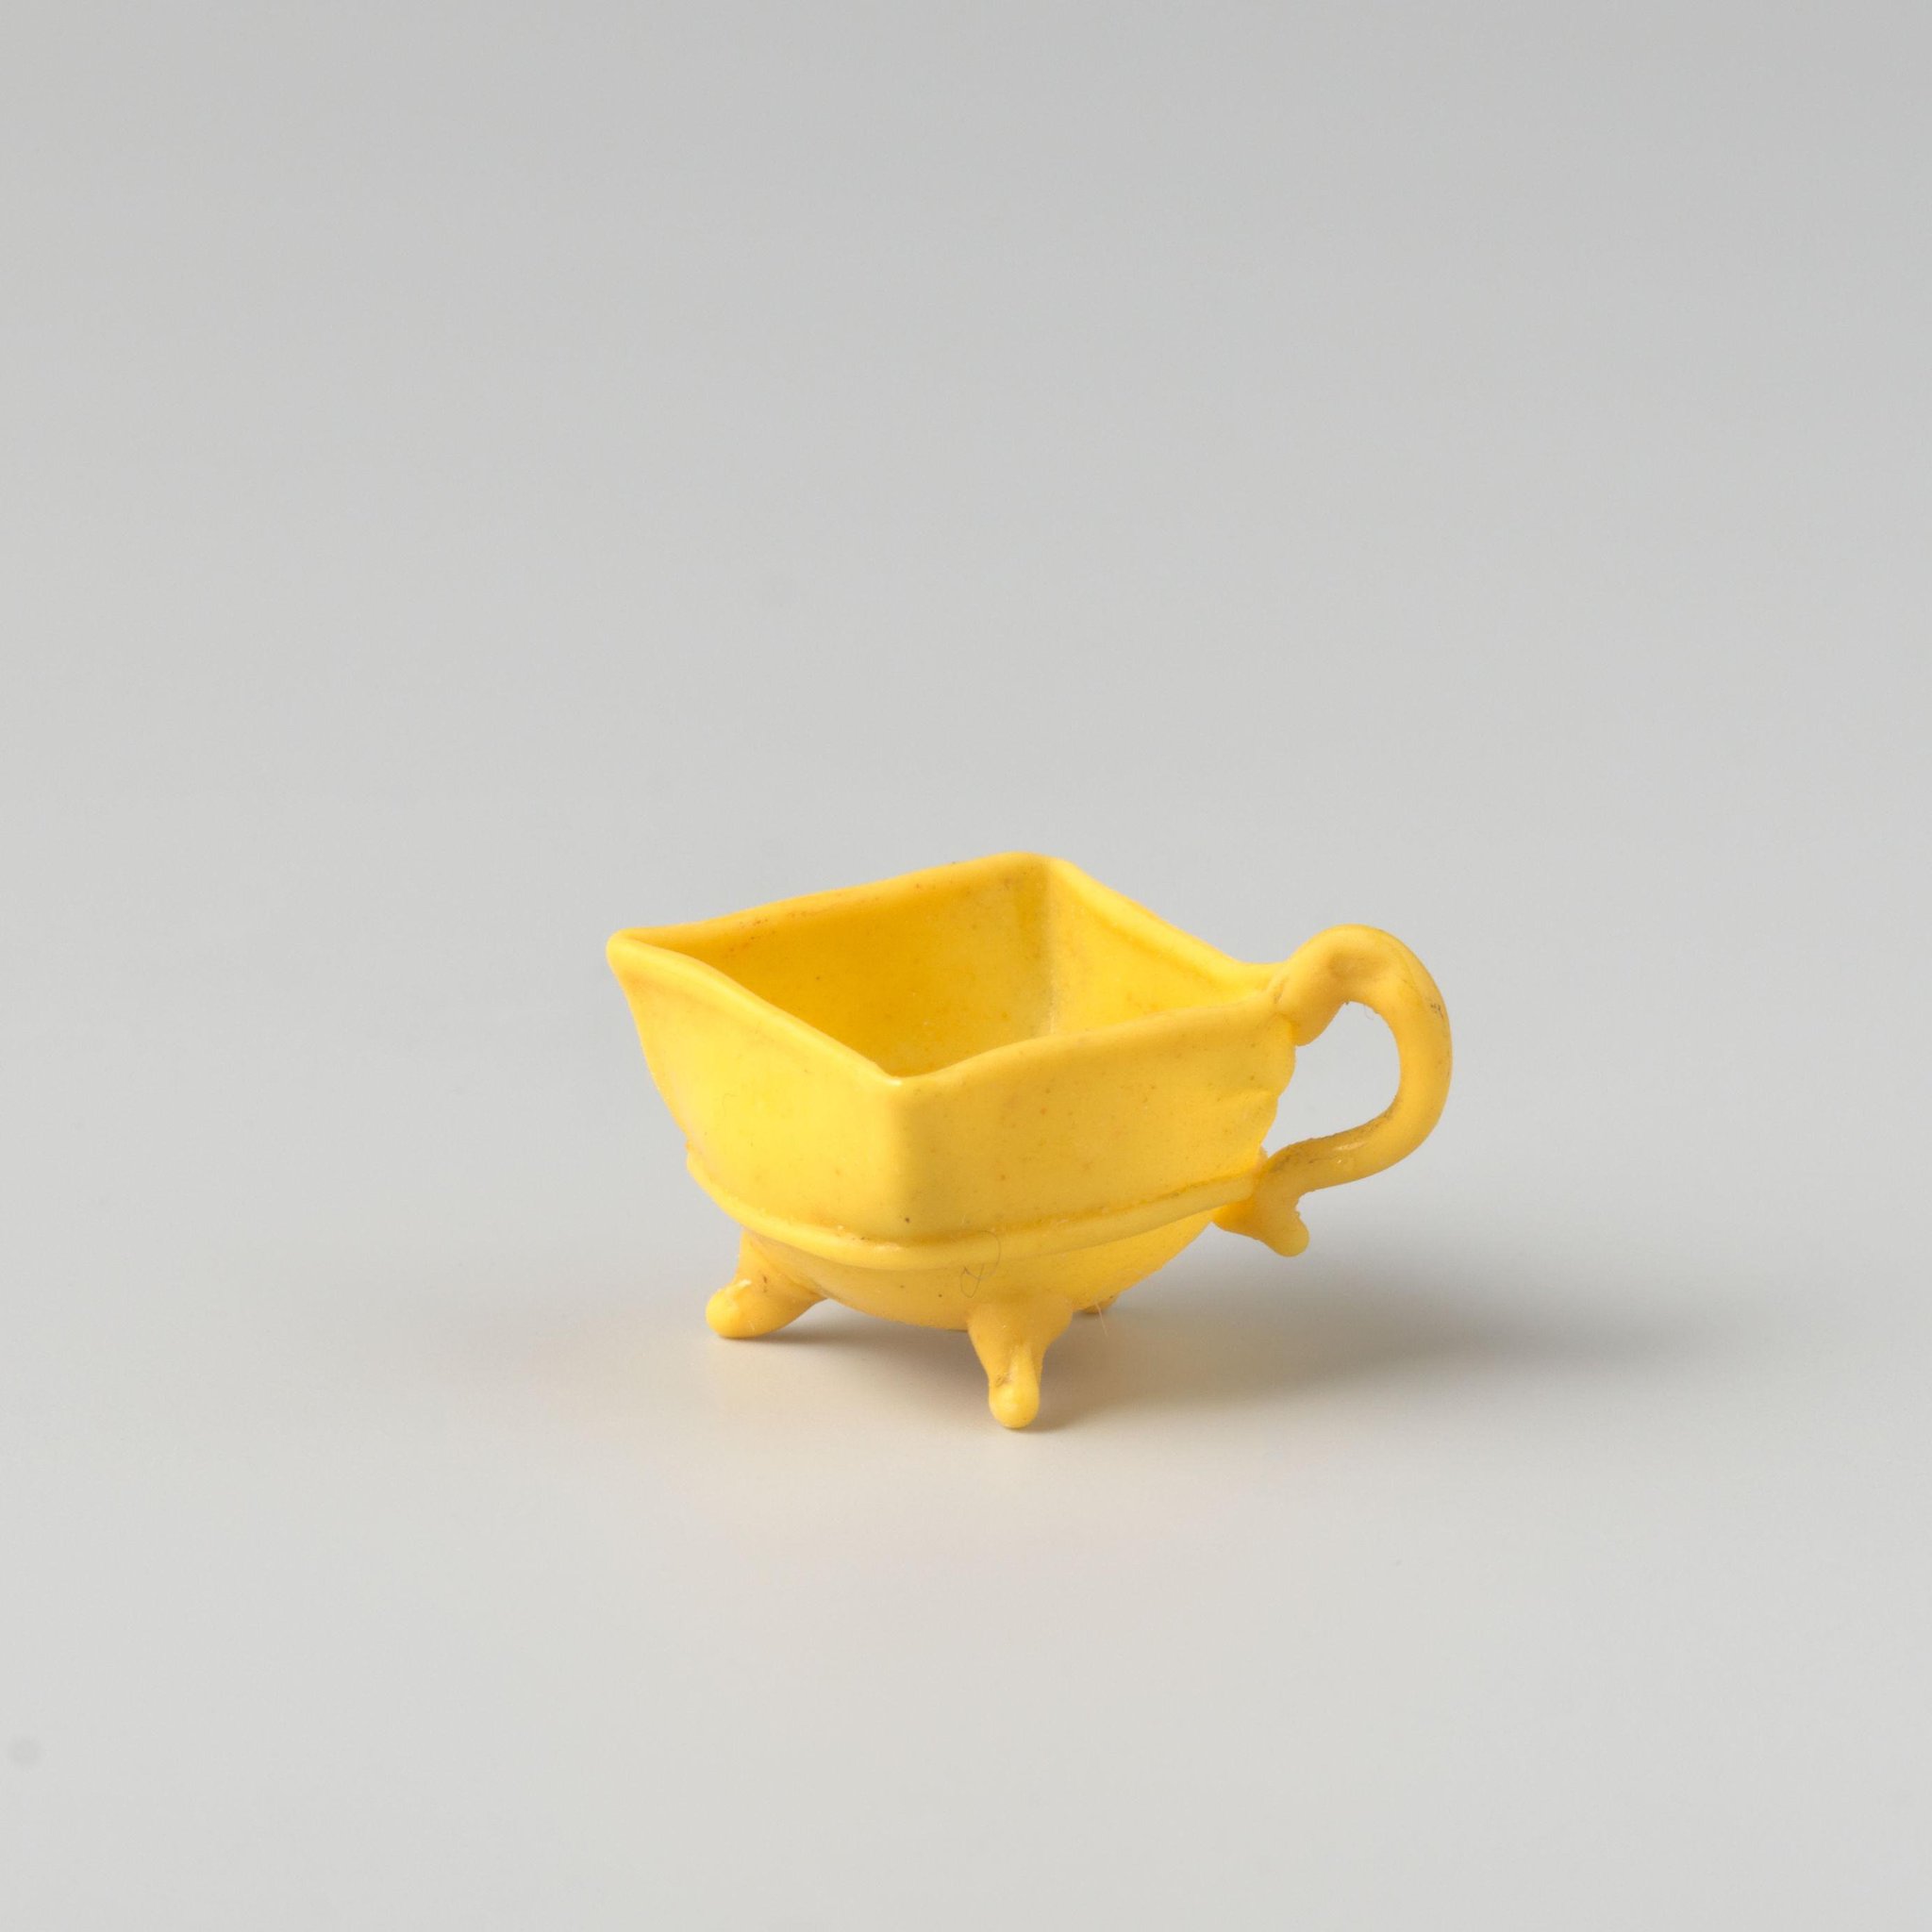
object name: vuurtest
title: Vierkante vuurtest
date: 1675-1700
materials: glass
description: Vierkante vuurtest op drie poten, van opaak geel glas.